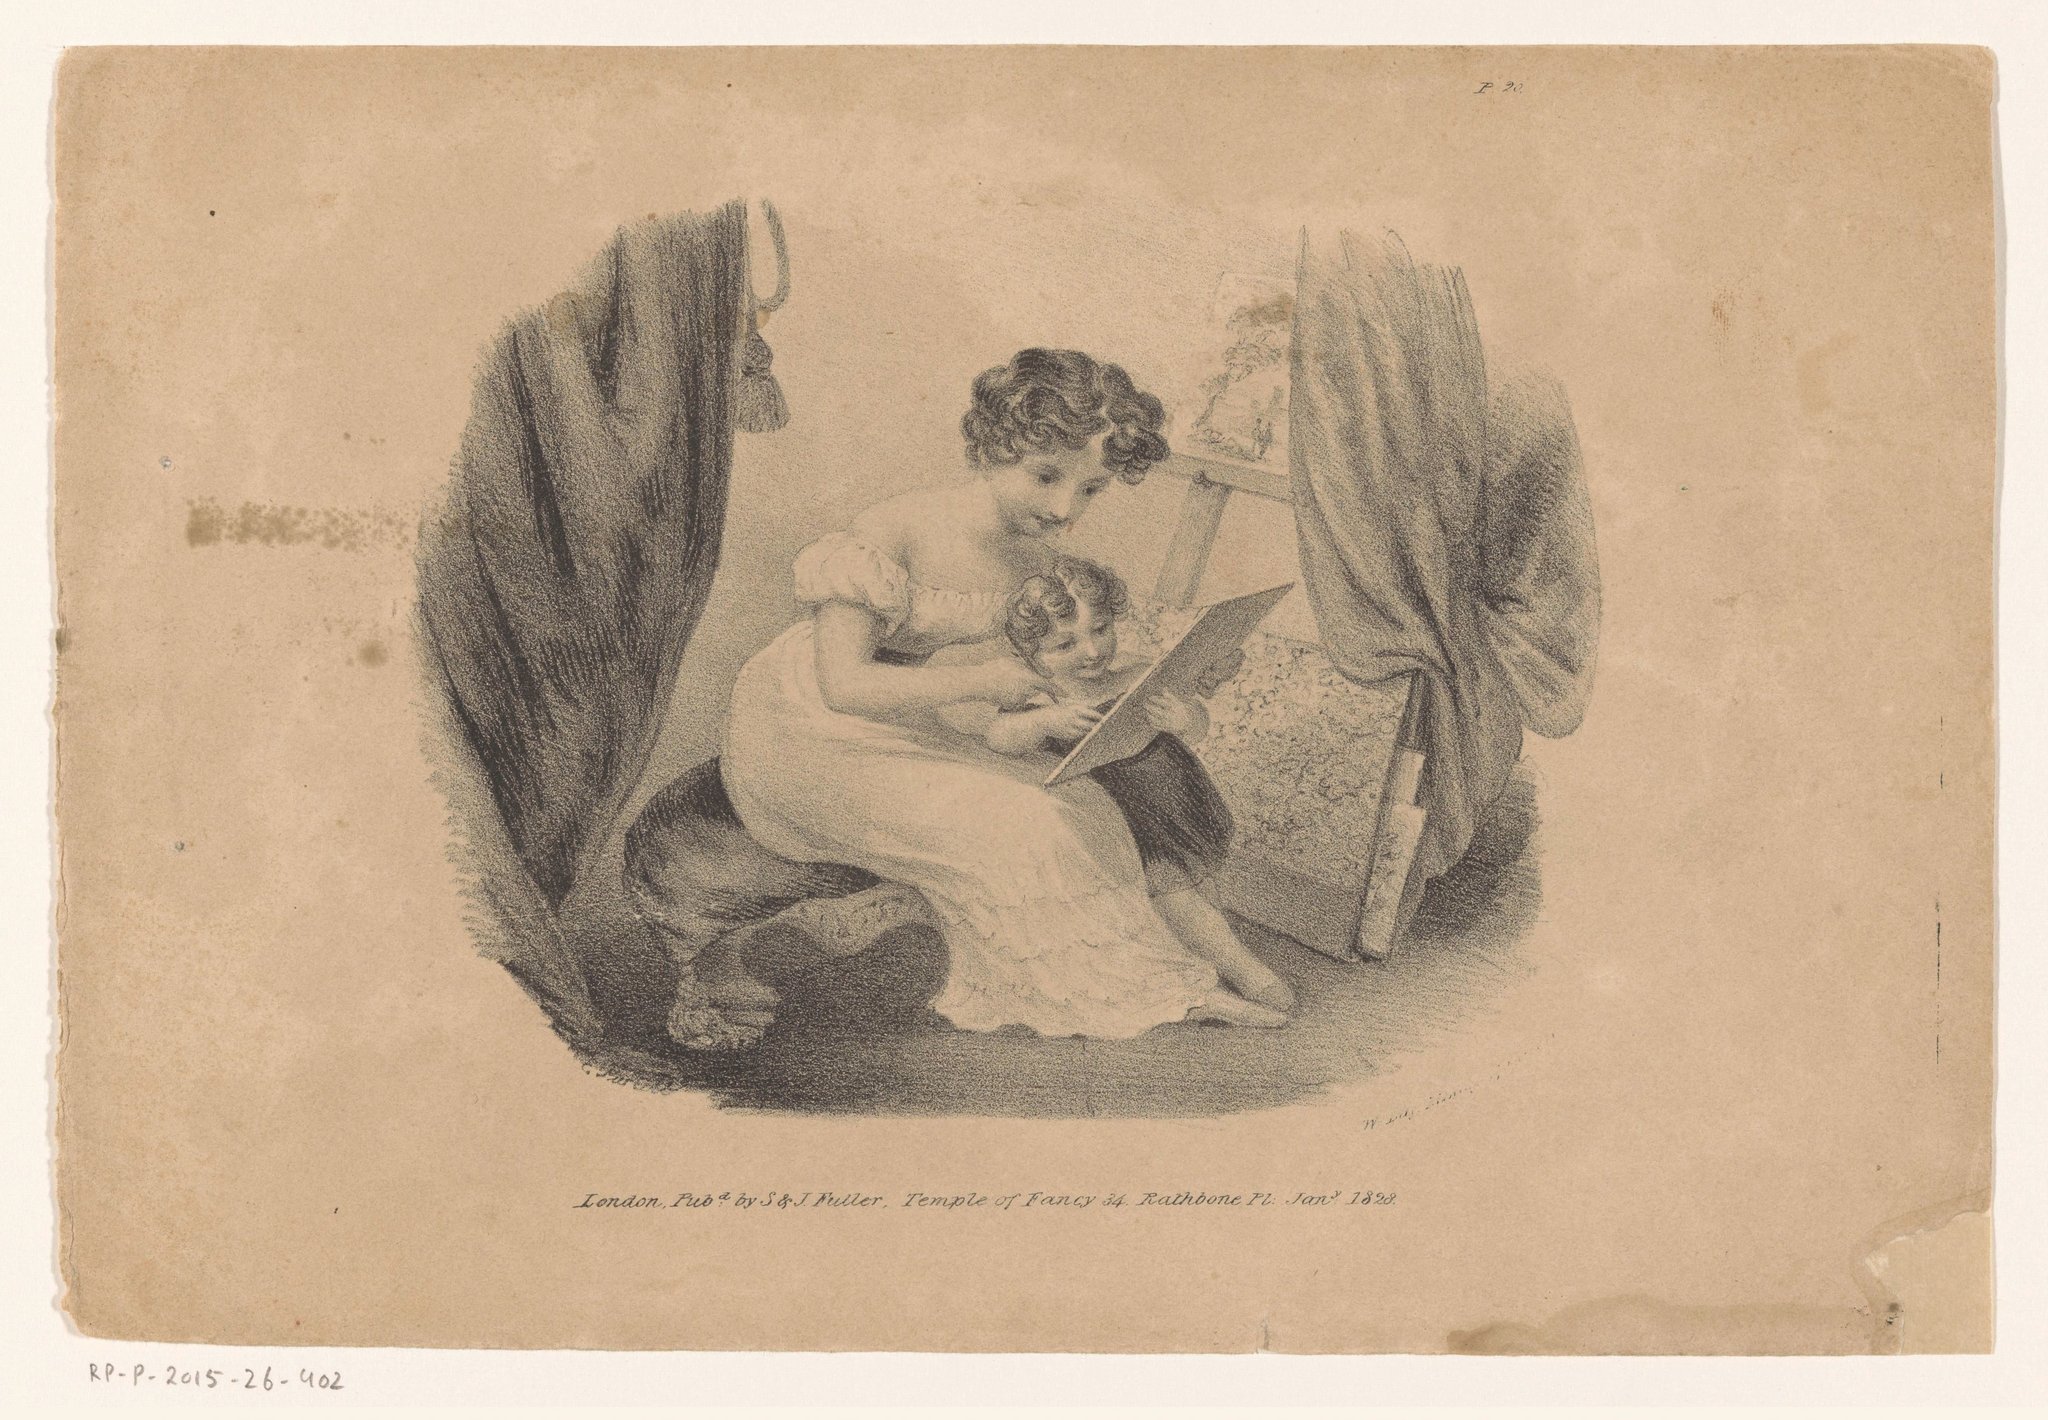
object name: print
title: Vrouw en kind bekijken een prent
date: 1828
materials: paper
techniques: lithograph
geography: london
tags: print, e.g.: engraving, etching, lithograph, easel, mother and child(ren), woman and child(ren) (family group)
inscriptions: collector's mark: Lugt 2228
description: De vrouw gezeten op een bankje met aan weerskanten gordijnen, in de achtergrond leunt een portfolio tegen een ezel met een schilderij.